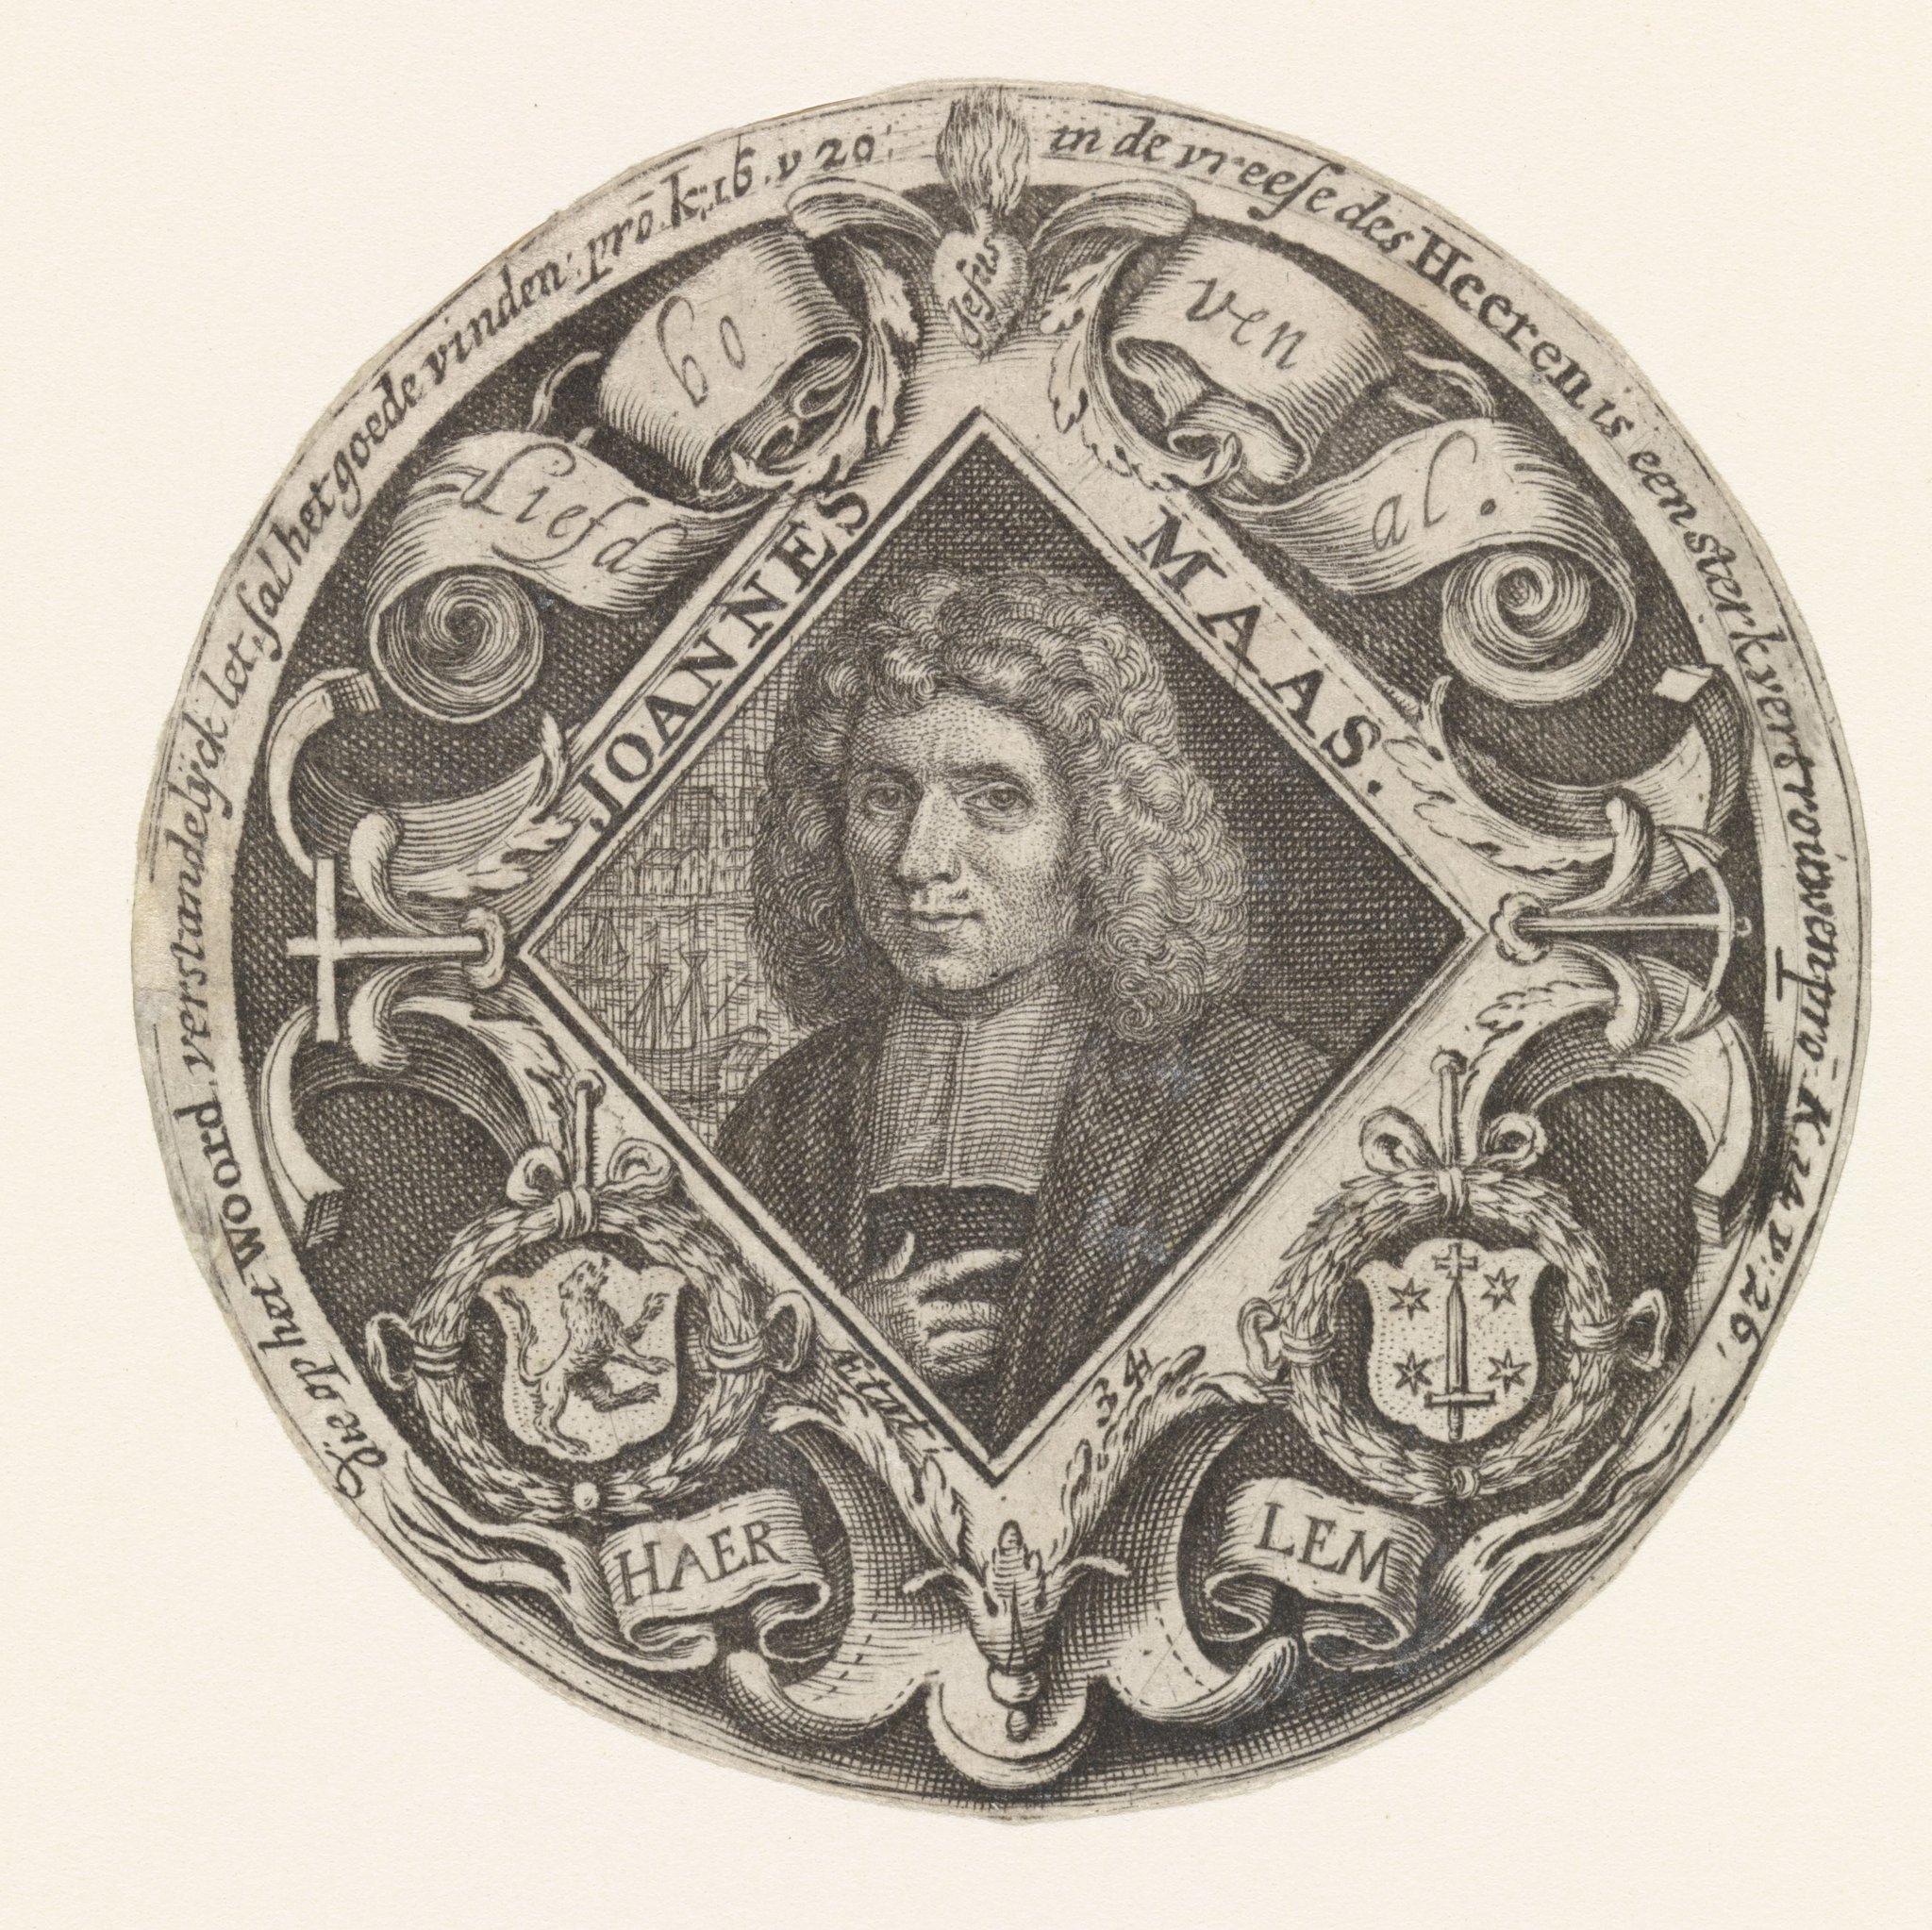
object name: print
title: Portret van Johannes Maas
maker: jacob matham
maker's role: draughtsman, print maker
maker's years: 1571-1631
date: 1695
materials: paper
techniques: engraving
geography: haarlem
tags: historical persons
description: Portret van Johannes Maas op 34-jarige leeftijd, in een ruitvormige omlijsting. Bovenaan een banderol met het devies: Liefde boven al. Onderaan de wapens van Holland (links) en Haarlem (rechts).